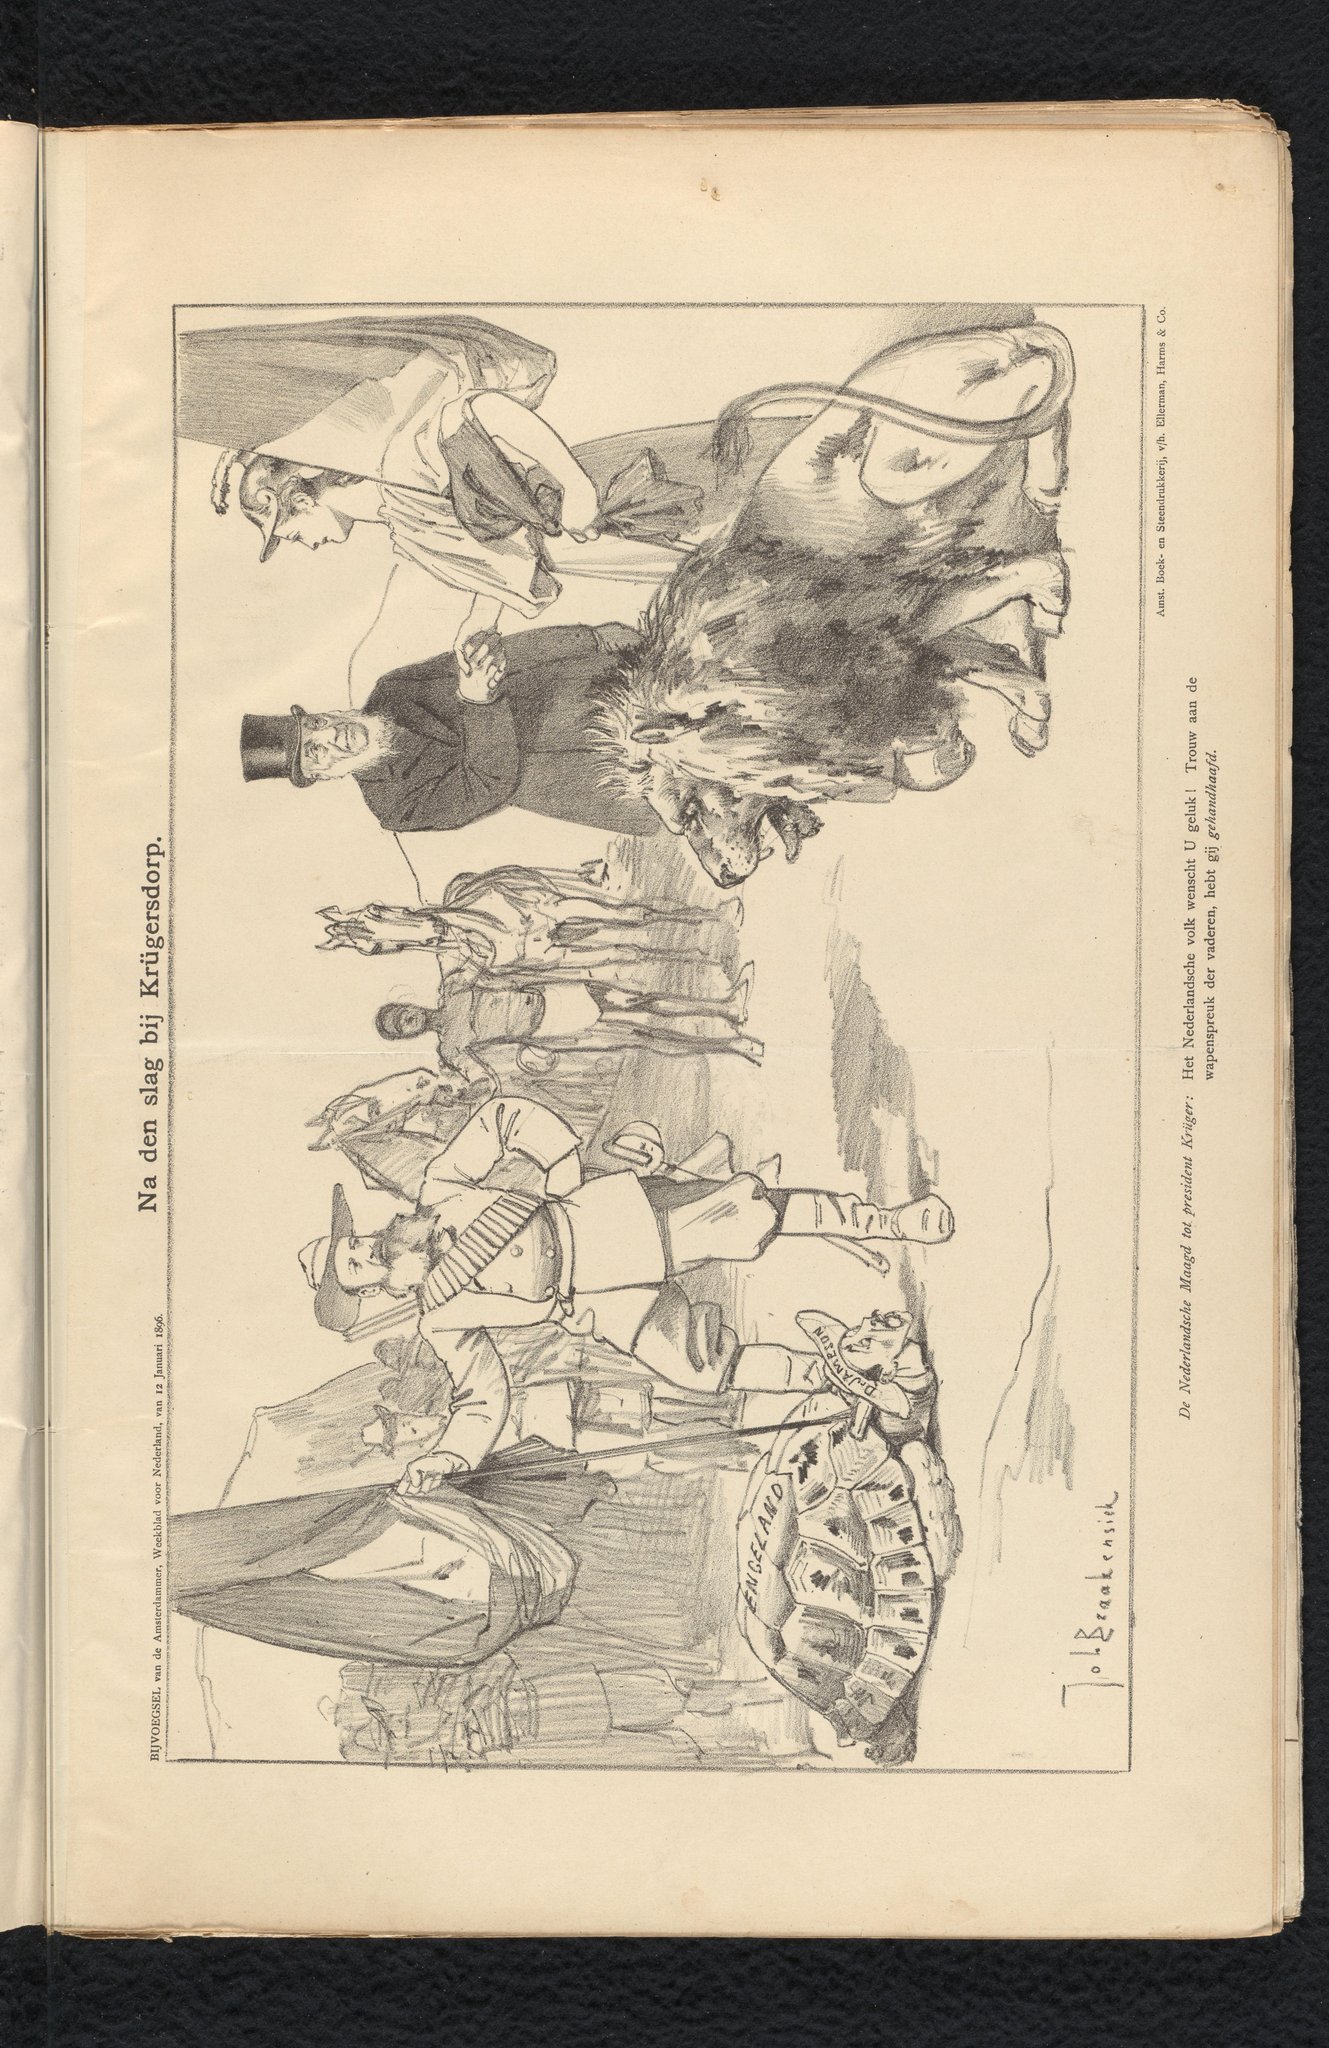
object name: cartoon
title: Na den slag bij Krügersdorp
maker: johan braakensiek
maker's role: draughtsman, print maker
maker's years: 1858-1940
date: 1896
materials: paper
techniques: lithograph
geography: netherlands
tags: london, tortoises, turtles, personifications of countries, nations, states, districts, etc., beasts of prey, predatory animals: lion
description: Paul Kruger met de Nederlandse Maagd en de Nederlandse Leeuw tegenover een verslagen schildpad, de Engelse Jameson Raid voorstellende. Een leider van de Boeren, waarschijnlijk Piet Cronjë, staat met vlag en voet op de schildpad.